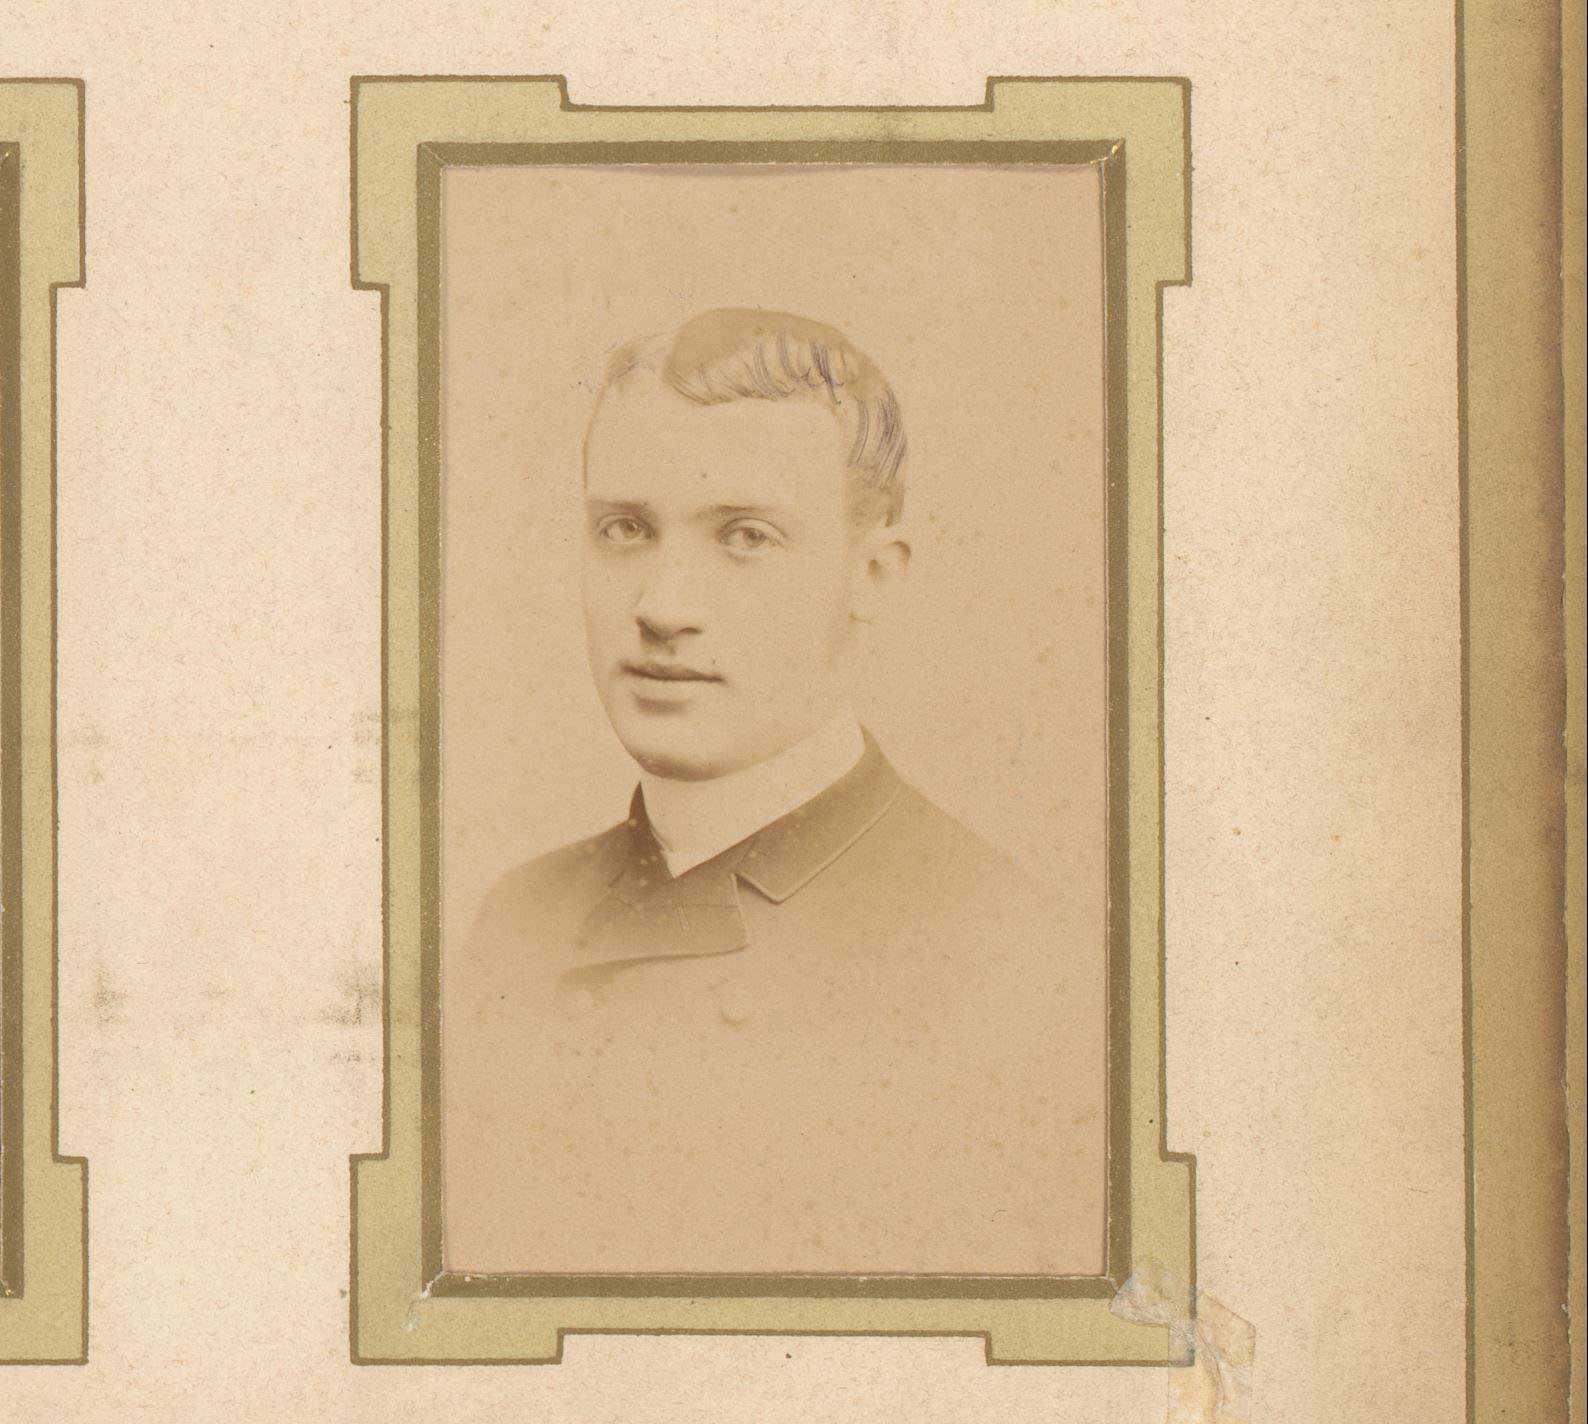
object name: carte de visite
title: Portret van een man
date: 1878-1900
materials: cardboard, photographic support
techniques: albumen print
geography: paris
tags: historical persons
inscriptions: inscription: ‘Photographie d'Art/ Bacard Fils/ Paris expon. Universelle 1878/ 31, Boulevard Bonne Nouvelle, 31/ Paris’